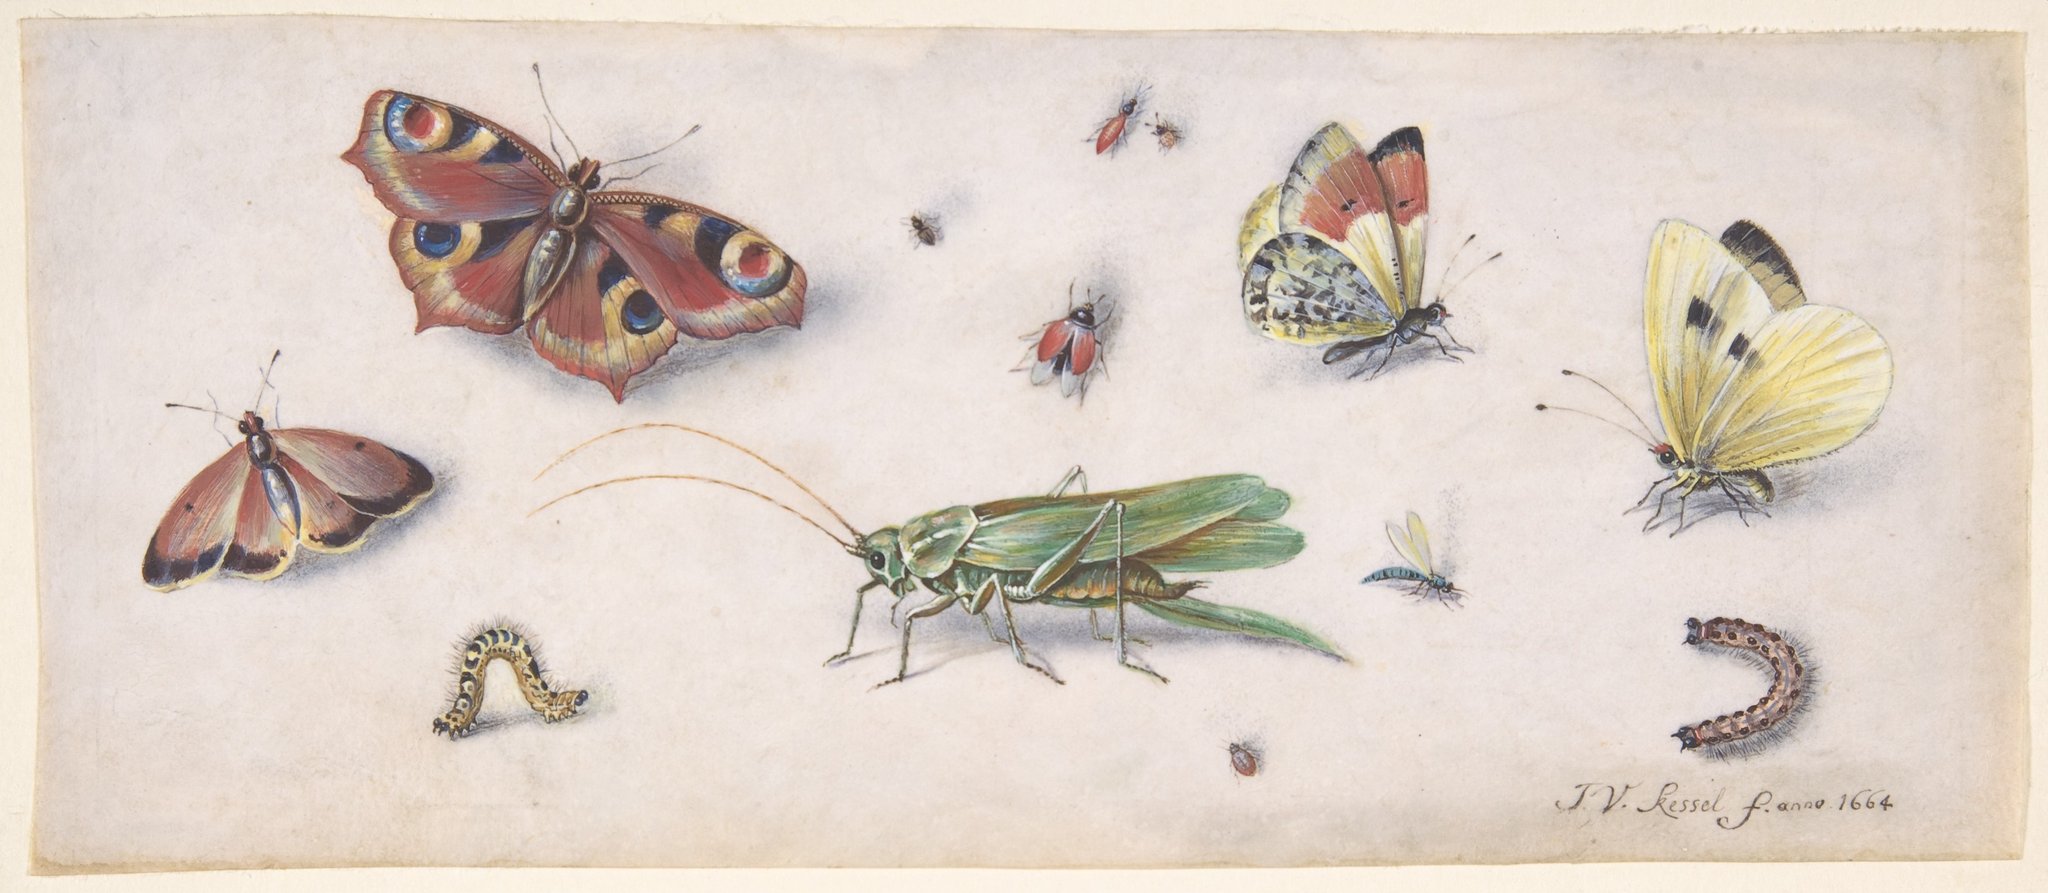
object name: drawing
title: Insects, Butterflies, and a Grasshopper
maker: jan van kessel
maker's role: artist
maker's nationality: flemish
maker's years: 1626-1679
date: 1664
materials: chalk, gouache, parchment, watercolor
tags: insects,butterflies